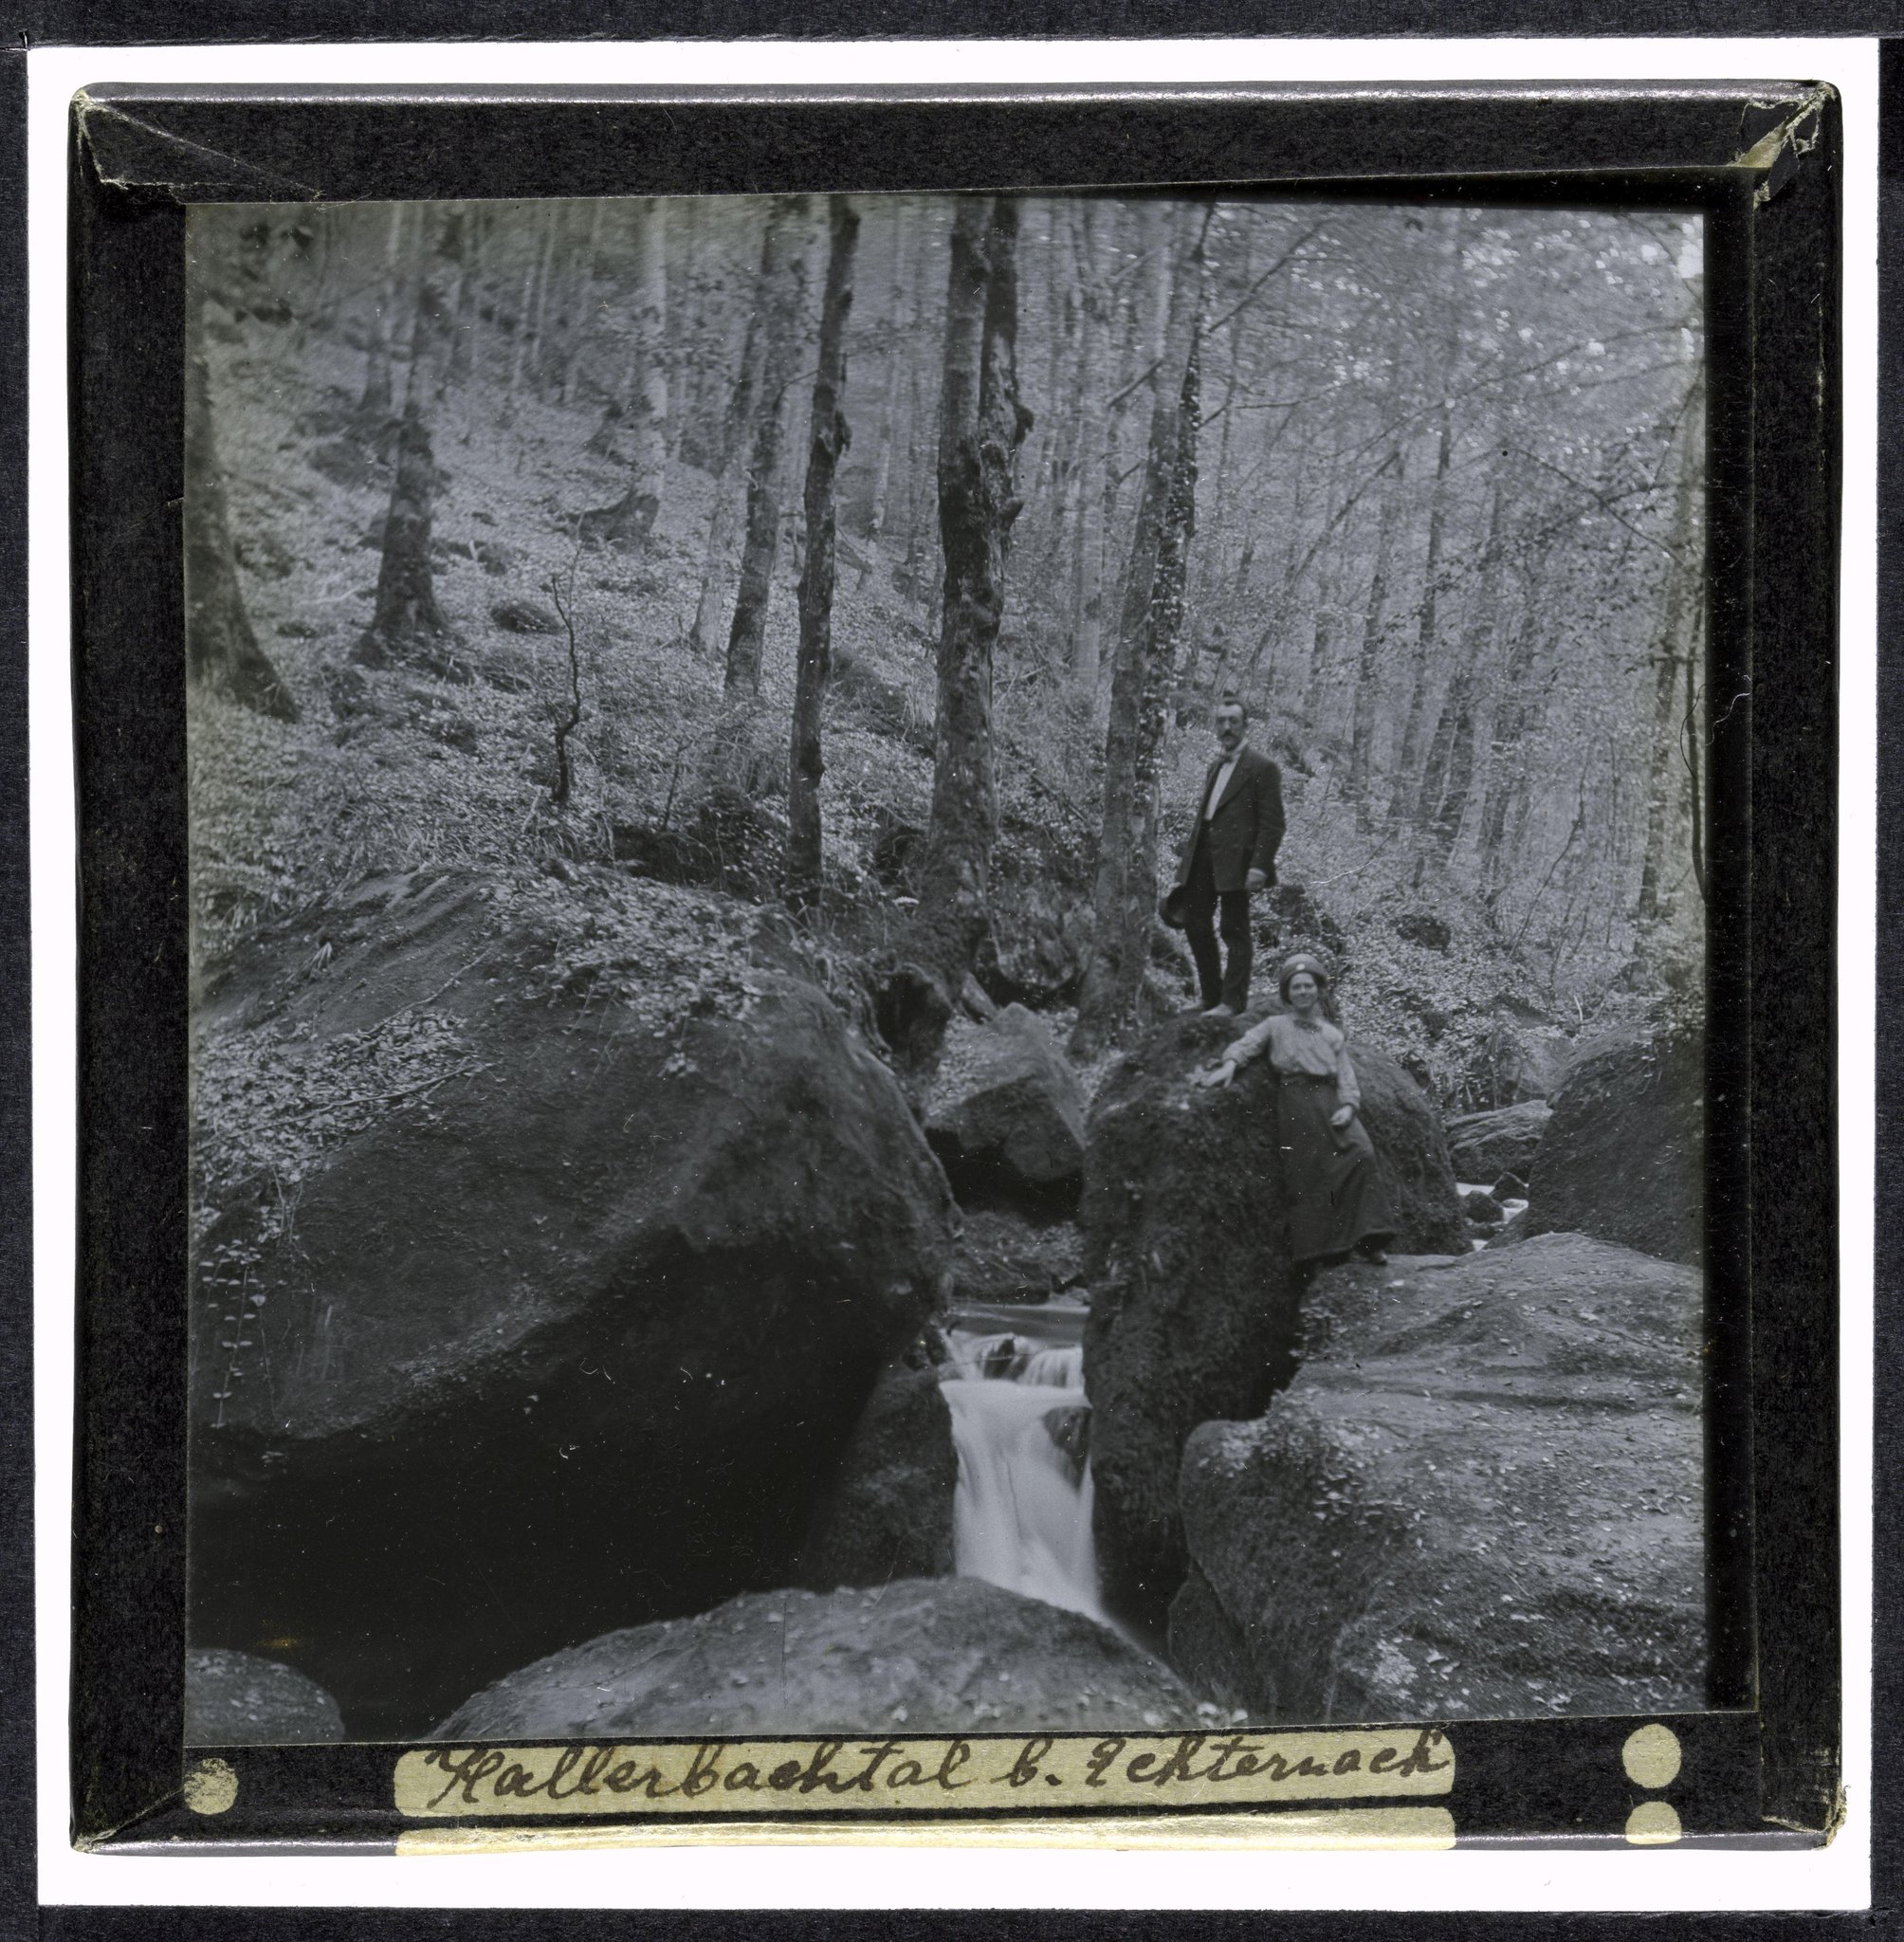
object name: photograph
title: Man en een vrouw bij rotsen en een rivier in een bos bij Echternach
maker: Anonymous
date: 1907-1935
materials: glass, ink, paper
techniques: slide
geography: echternach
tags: river, forest, wood